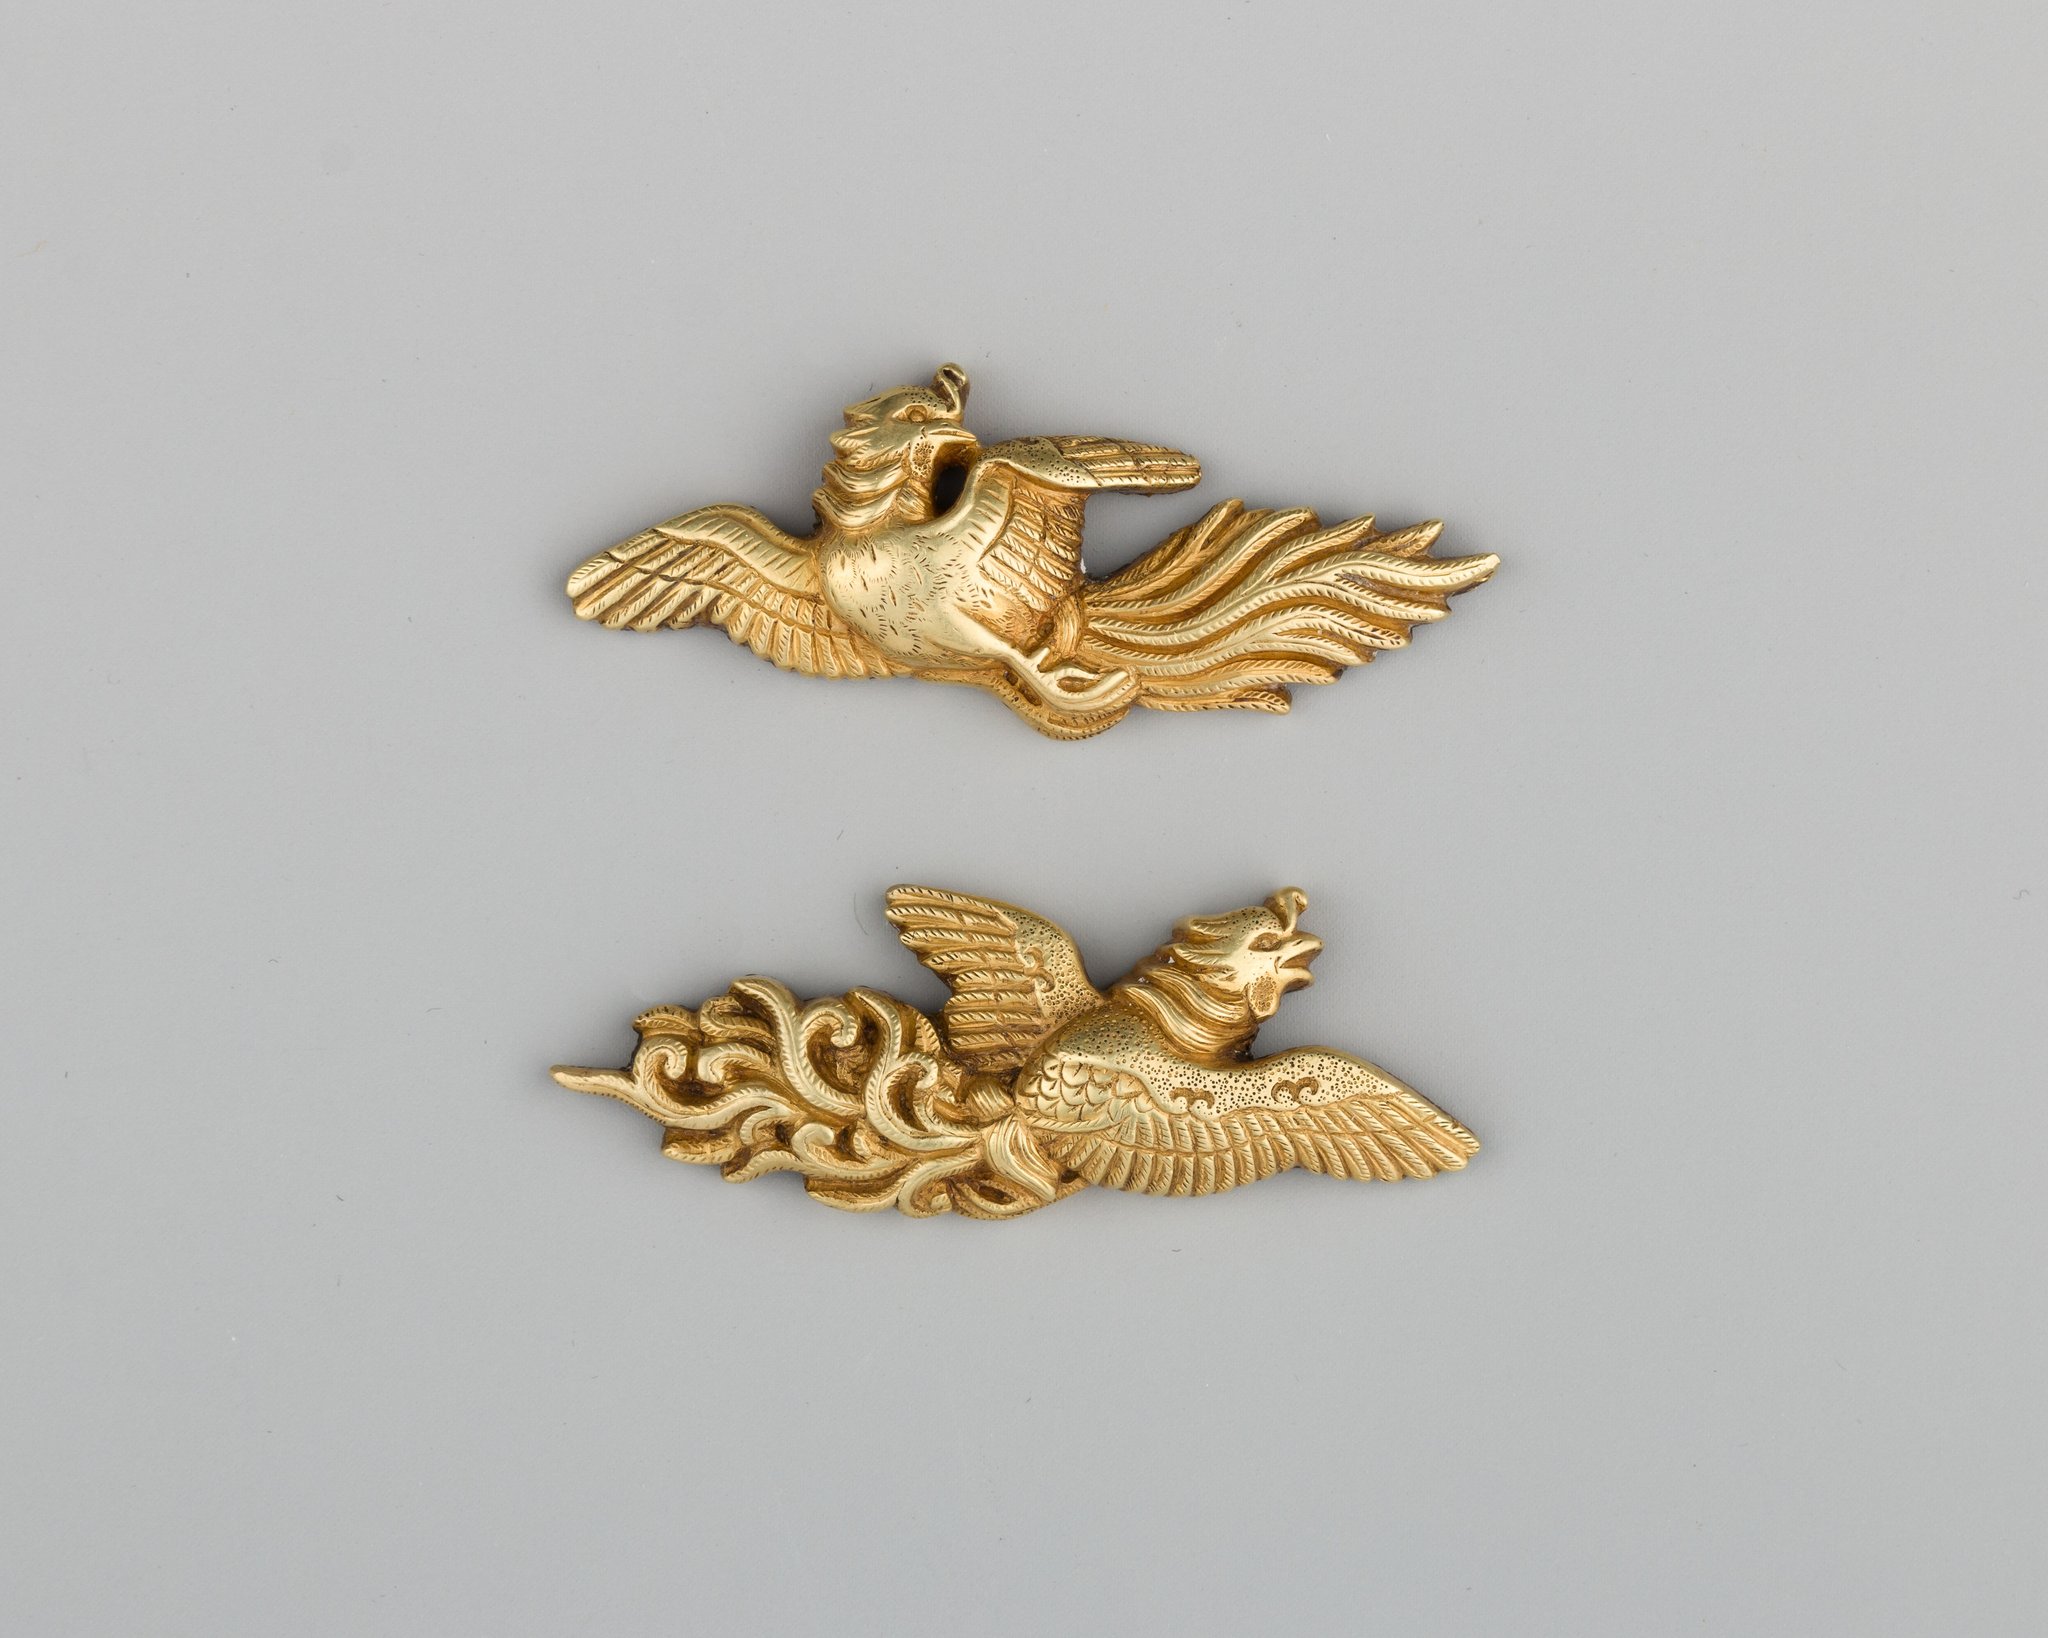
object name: pair of sword grip ornament menuki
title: Pair of Sword-Grip Ornaments (Menuki)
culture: japanese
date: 1701-1800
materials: gold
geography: japan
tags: birds